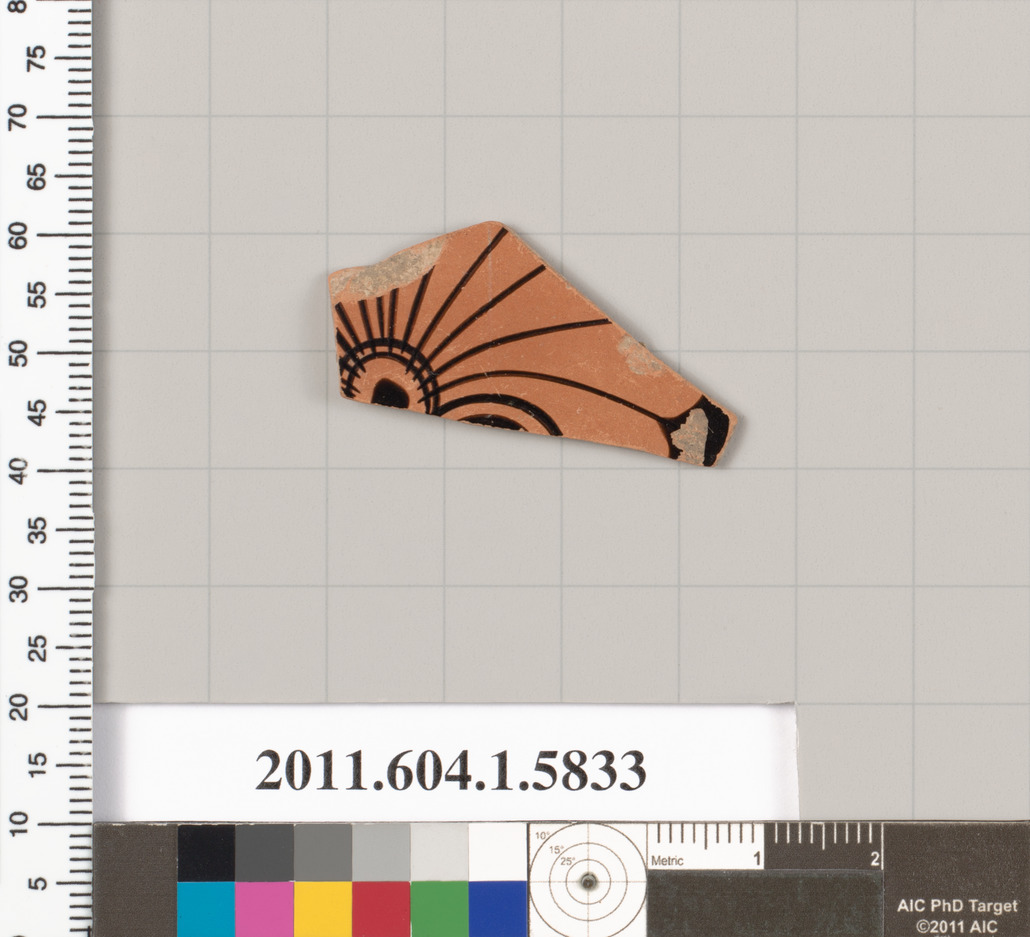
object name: kylix fragment, eye cup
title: Terracotta fragment of a kylix: eye-cup (drinking cup)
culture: greek, attic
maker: painter of the boulogne horse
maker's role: artist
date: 520-510 BCE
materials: terracotta